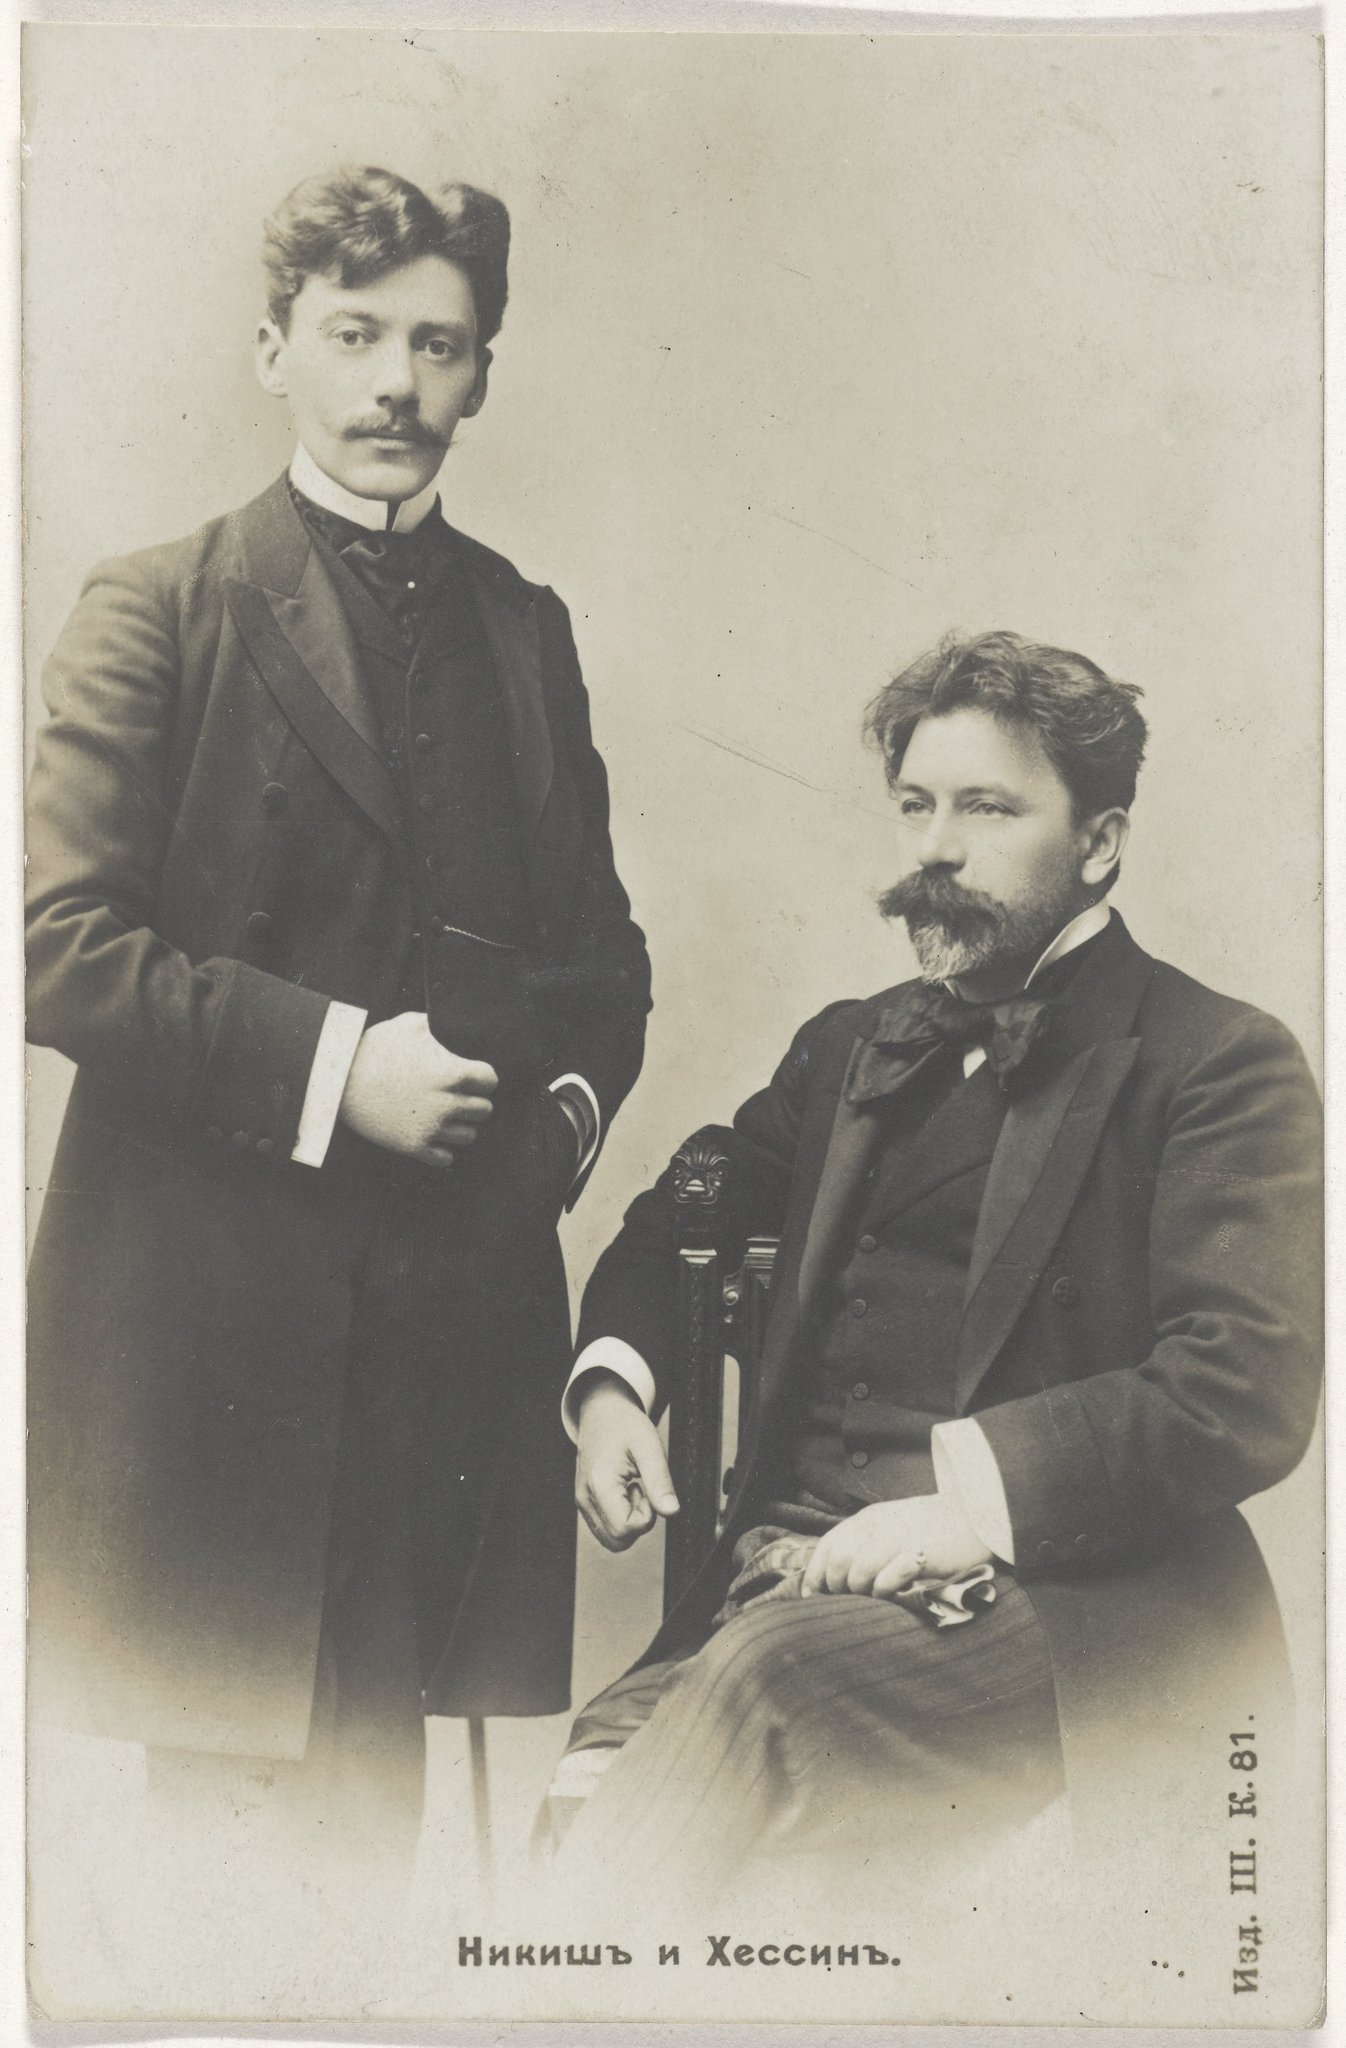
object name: ansichtkaart, prentbriefkaart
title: Portret van de Hongaarse dirigent Artúr Nikisch, (zittend) en de Russische componist/dirigent Aleksandr Borisovich Chessin.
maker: Anonymous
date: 1900-1940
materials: photographic support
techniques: gelatin silver print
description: Portret van de Hongaarse dirigent Artúr Nikisch, (zittend) en de Russische componist/dirigent Aleksandr Borisovich Chessin (of Hessin). Nikish is één van de grondleggers van de moderne school van dirigeren